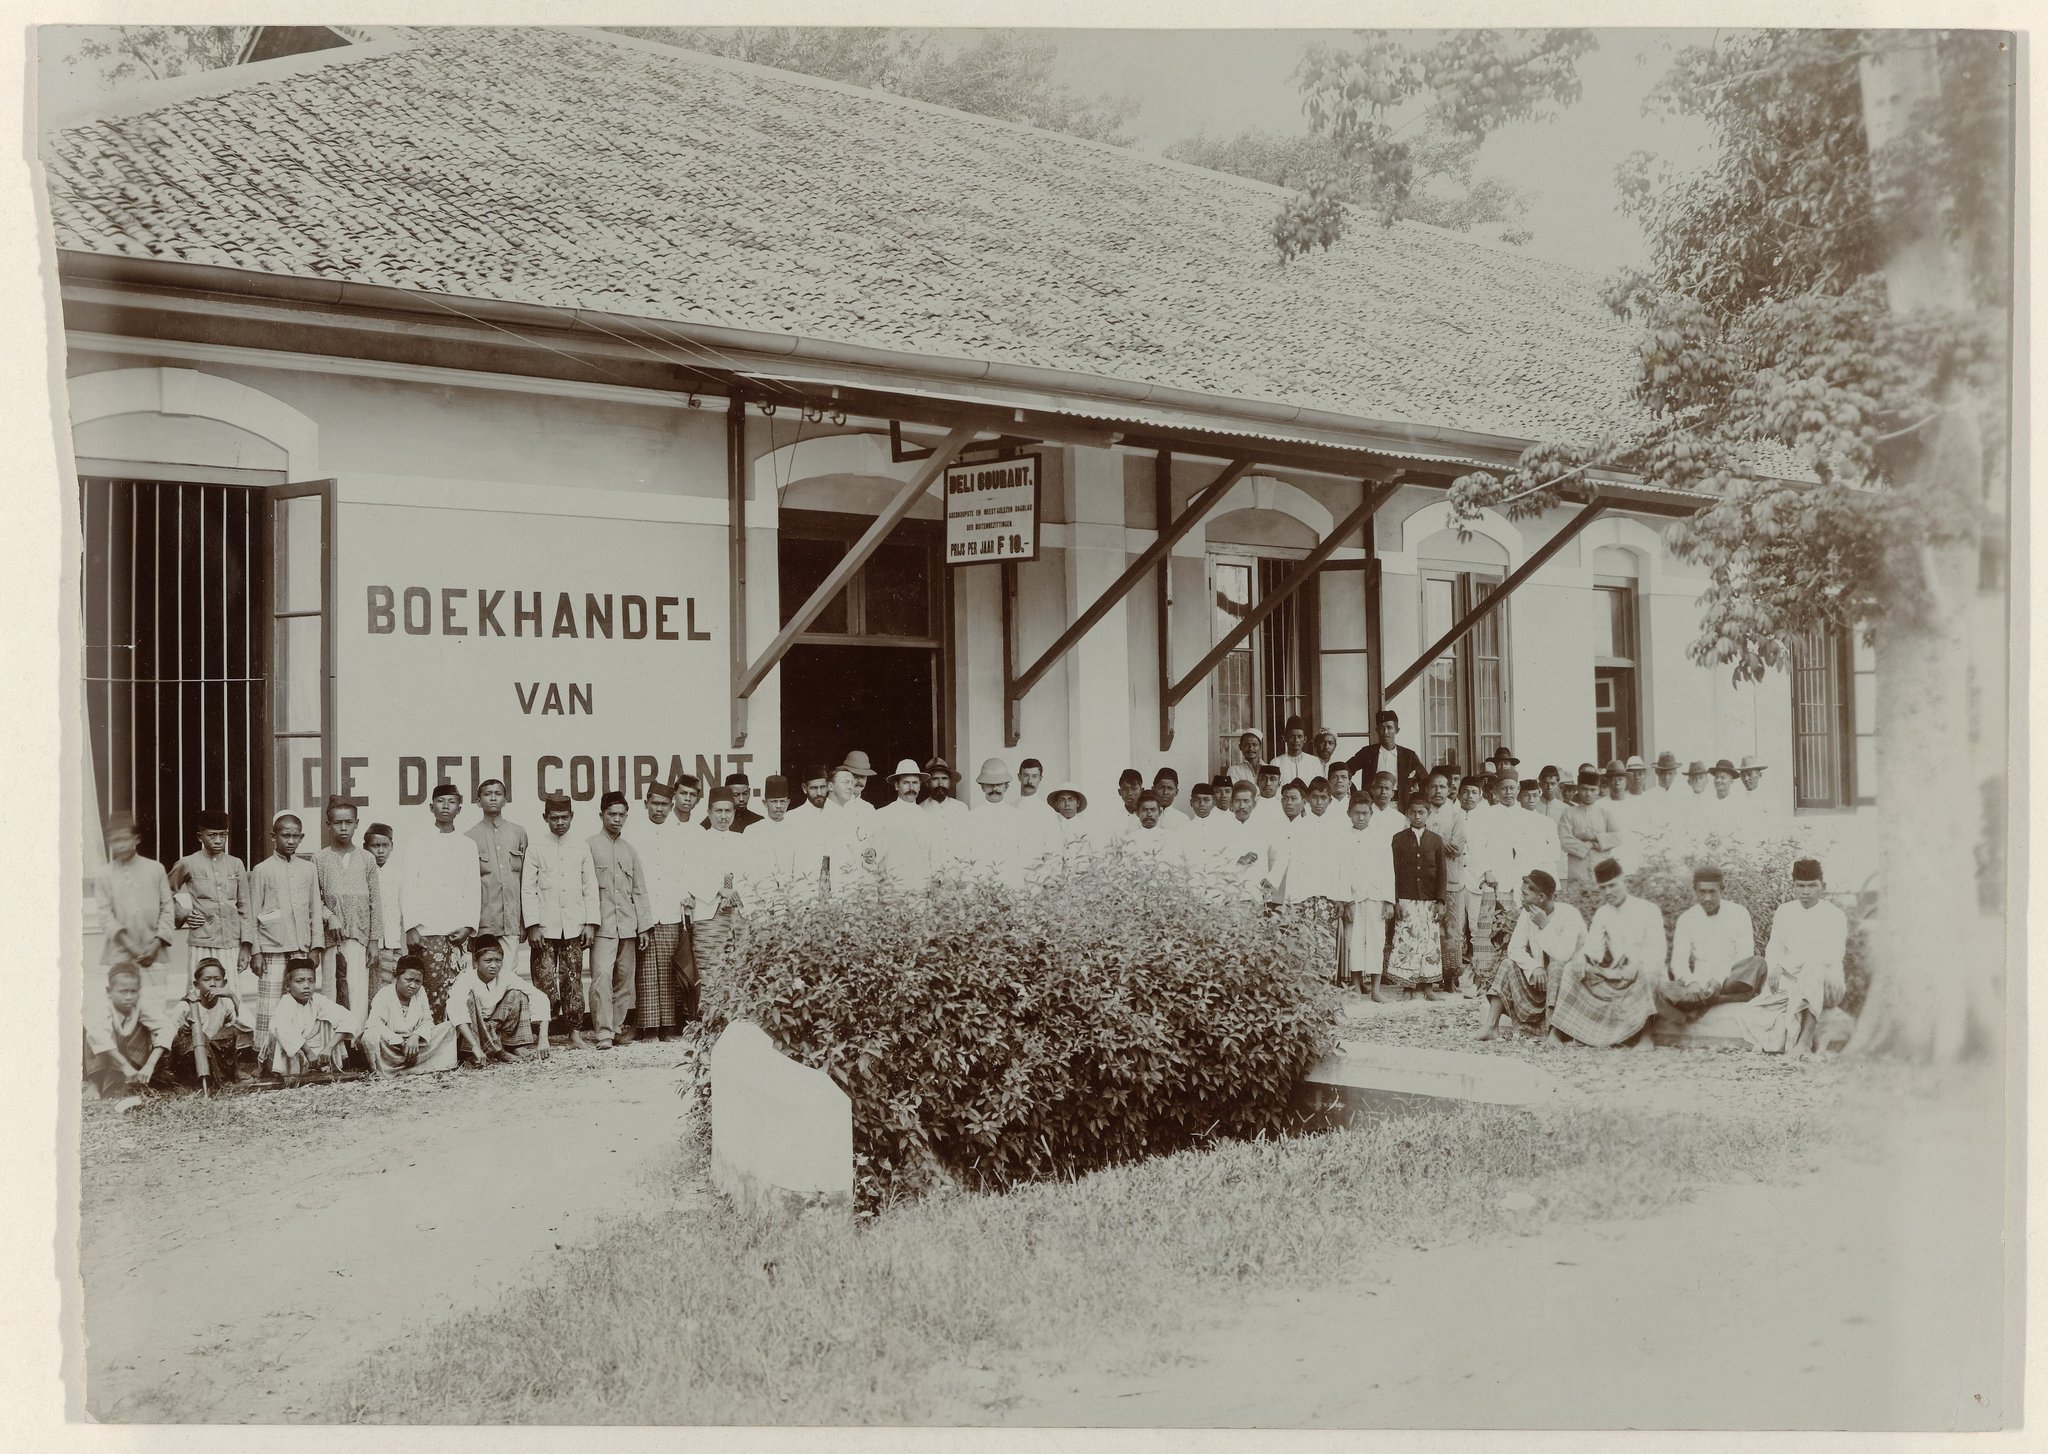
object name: photograph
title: Gebouw van de Deli Courant te Medan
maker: Anonymous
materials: photographic support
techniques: collodion silver print, gelatin silver print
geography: medan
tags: dutch east indies, the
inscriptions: inscription: ‘voorzijde gebouw’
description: Het gebouw van de drukkerij en boekhandel van de Deli Courant te Medan met het personeel poserend buiten voor de ingang. Onderdeel van een aparte groep van negen foto's uit 1908 binnen de gehele groep van 49 losse zwart-wit foto's van verschillend formaat over de uitgeverij en drukkerij van de krant Deli Courant in Medan in de periode 1885-1947.